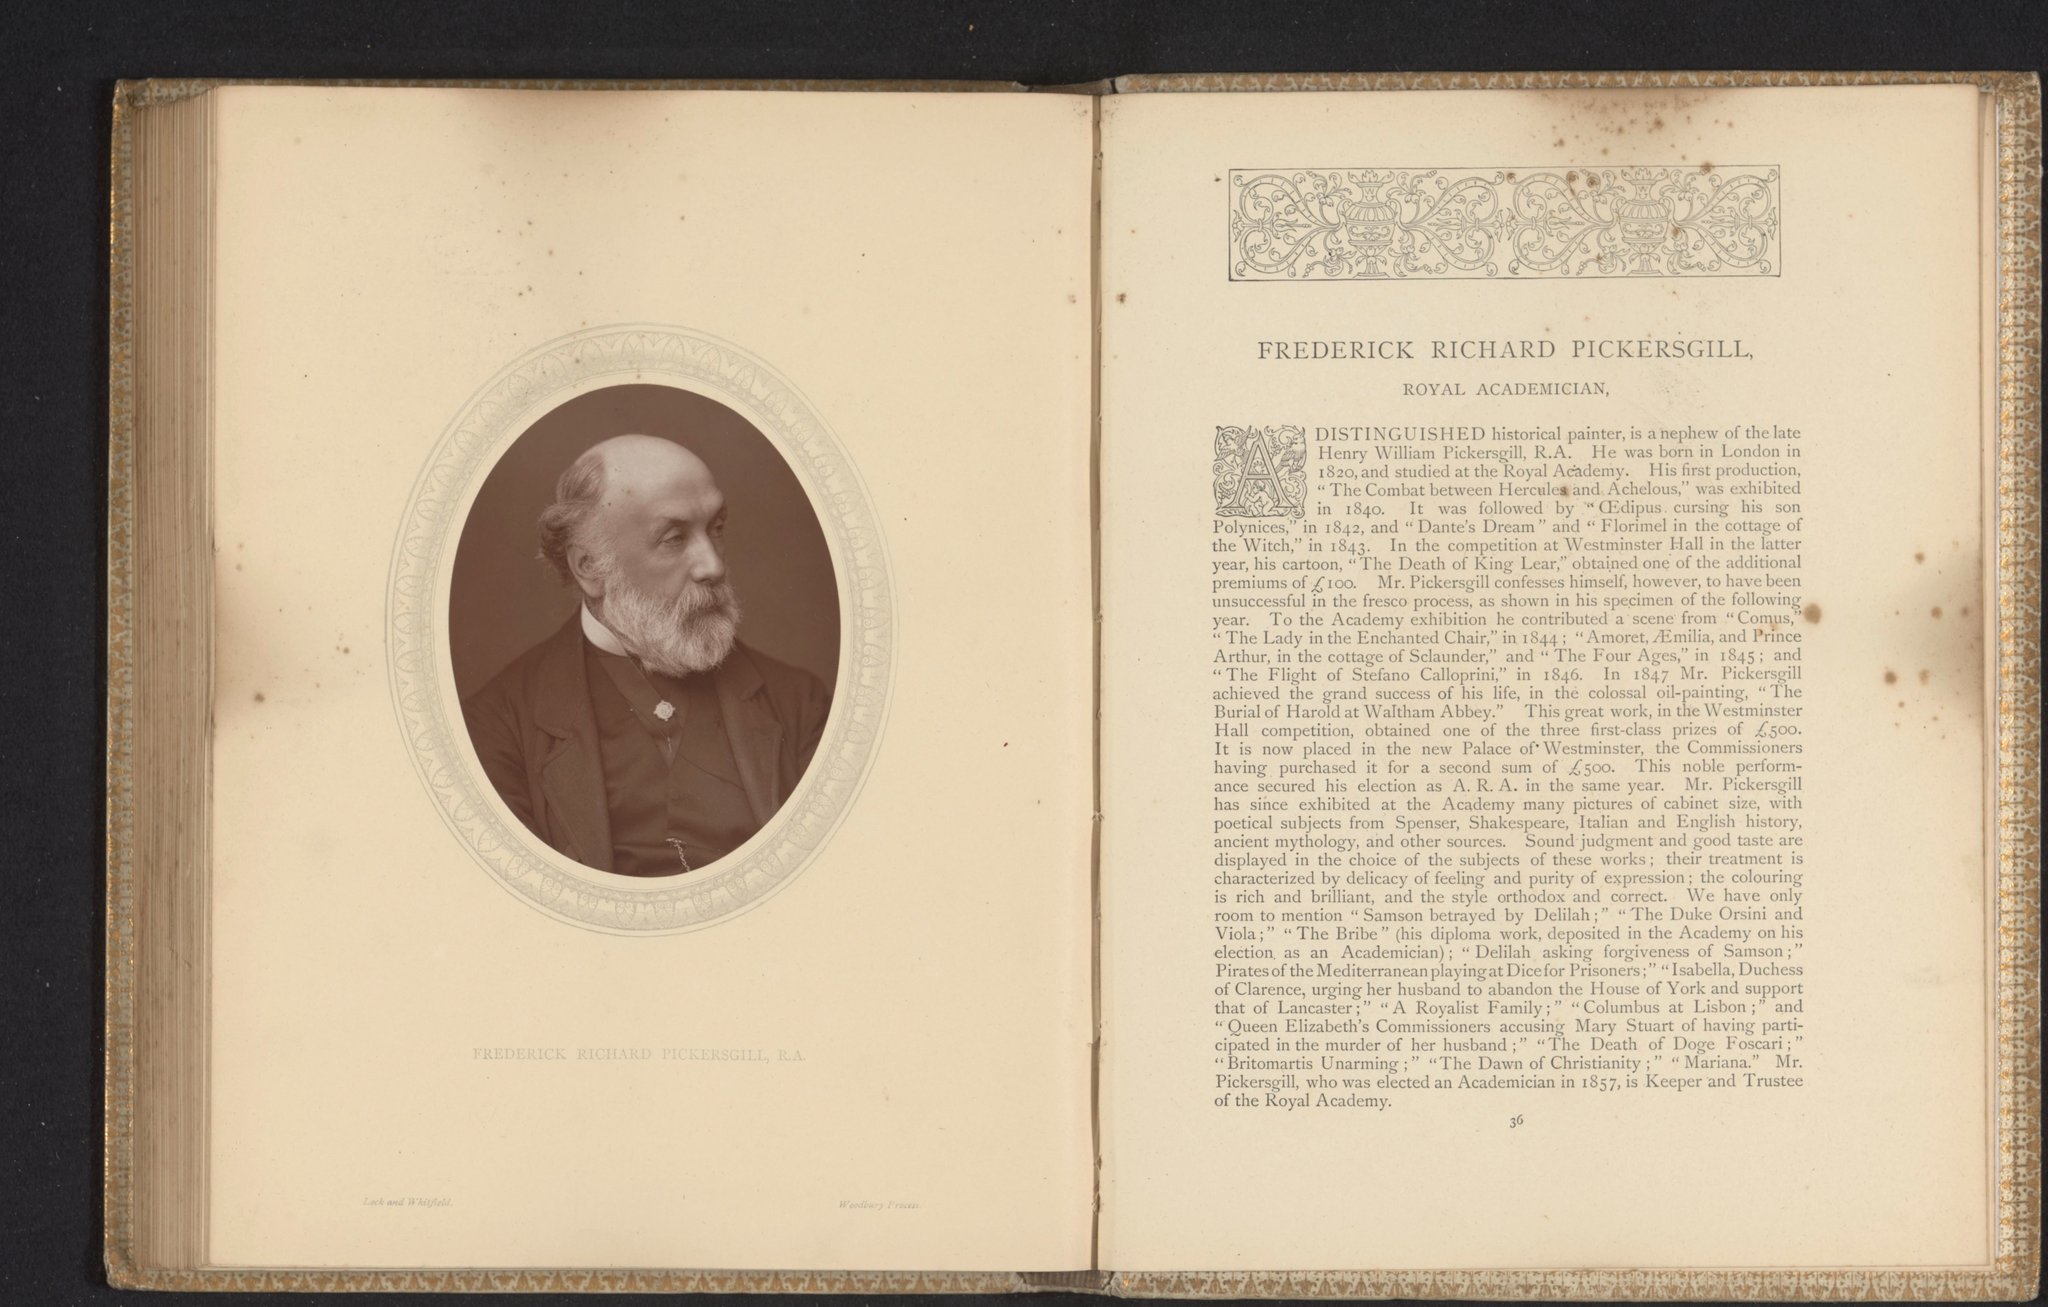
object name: photomechanical print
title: Frederick Richard Pickersgill, R.A.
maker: Anonymous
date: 1877-1882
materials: paper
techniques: woodburytype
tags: portrait, self-portrait of painter, historical persons (portraits and scenes from the life) (+ (full) bust portrait)